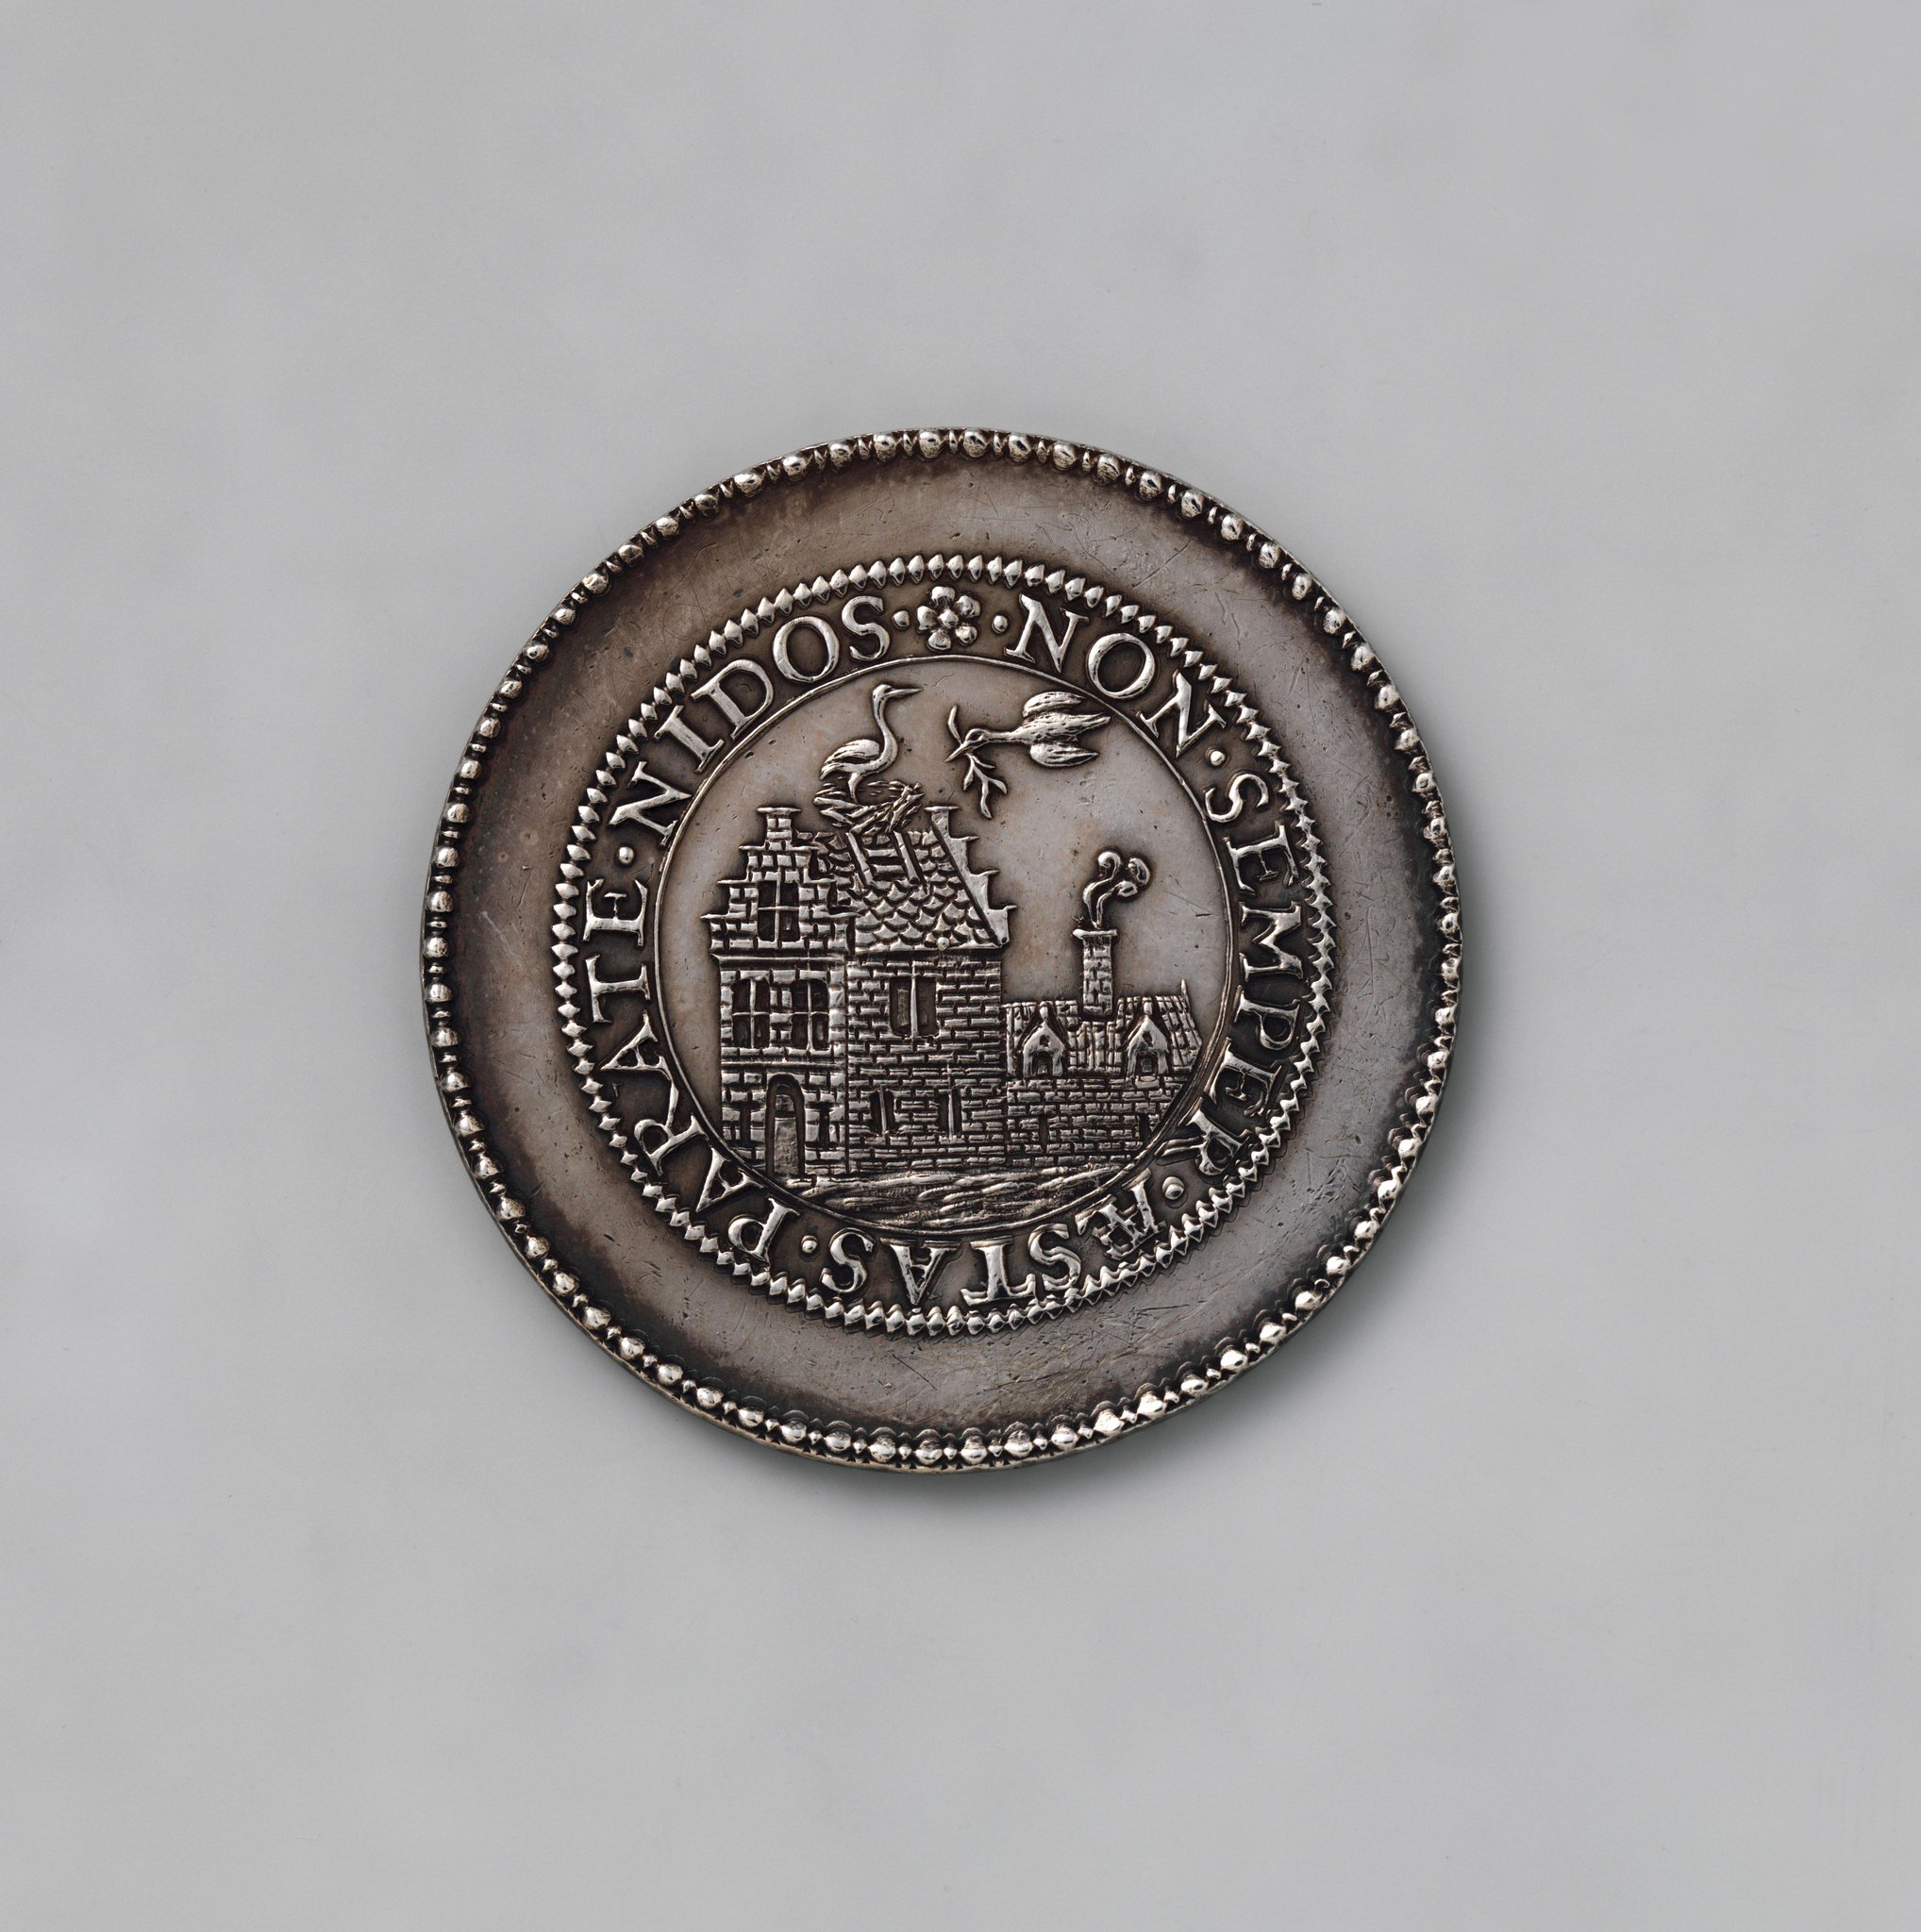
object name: triomfpenning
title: Incitement to Vigilance and Concord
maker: gerard van bylaer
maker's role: die cutter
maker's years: 1540-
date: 1591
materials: silver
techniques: striking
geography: dordrecht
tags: tachtigjarige oorlog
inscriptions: circumscription: ‘CONIVNCTIS VIRIBVS ITE / 1591’, circumscription: ‘NON SEMPER AESTAS PARATE NIDOS’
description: Zilveren penning. Voorzijde: ooievaars die nest bouwen op dak van een huis binnen omschrift. Keerzijde: Romeinse galei onder jaartal binnen omschrift.